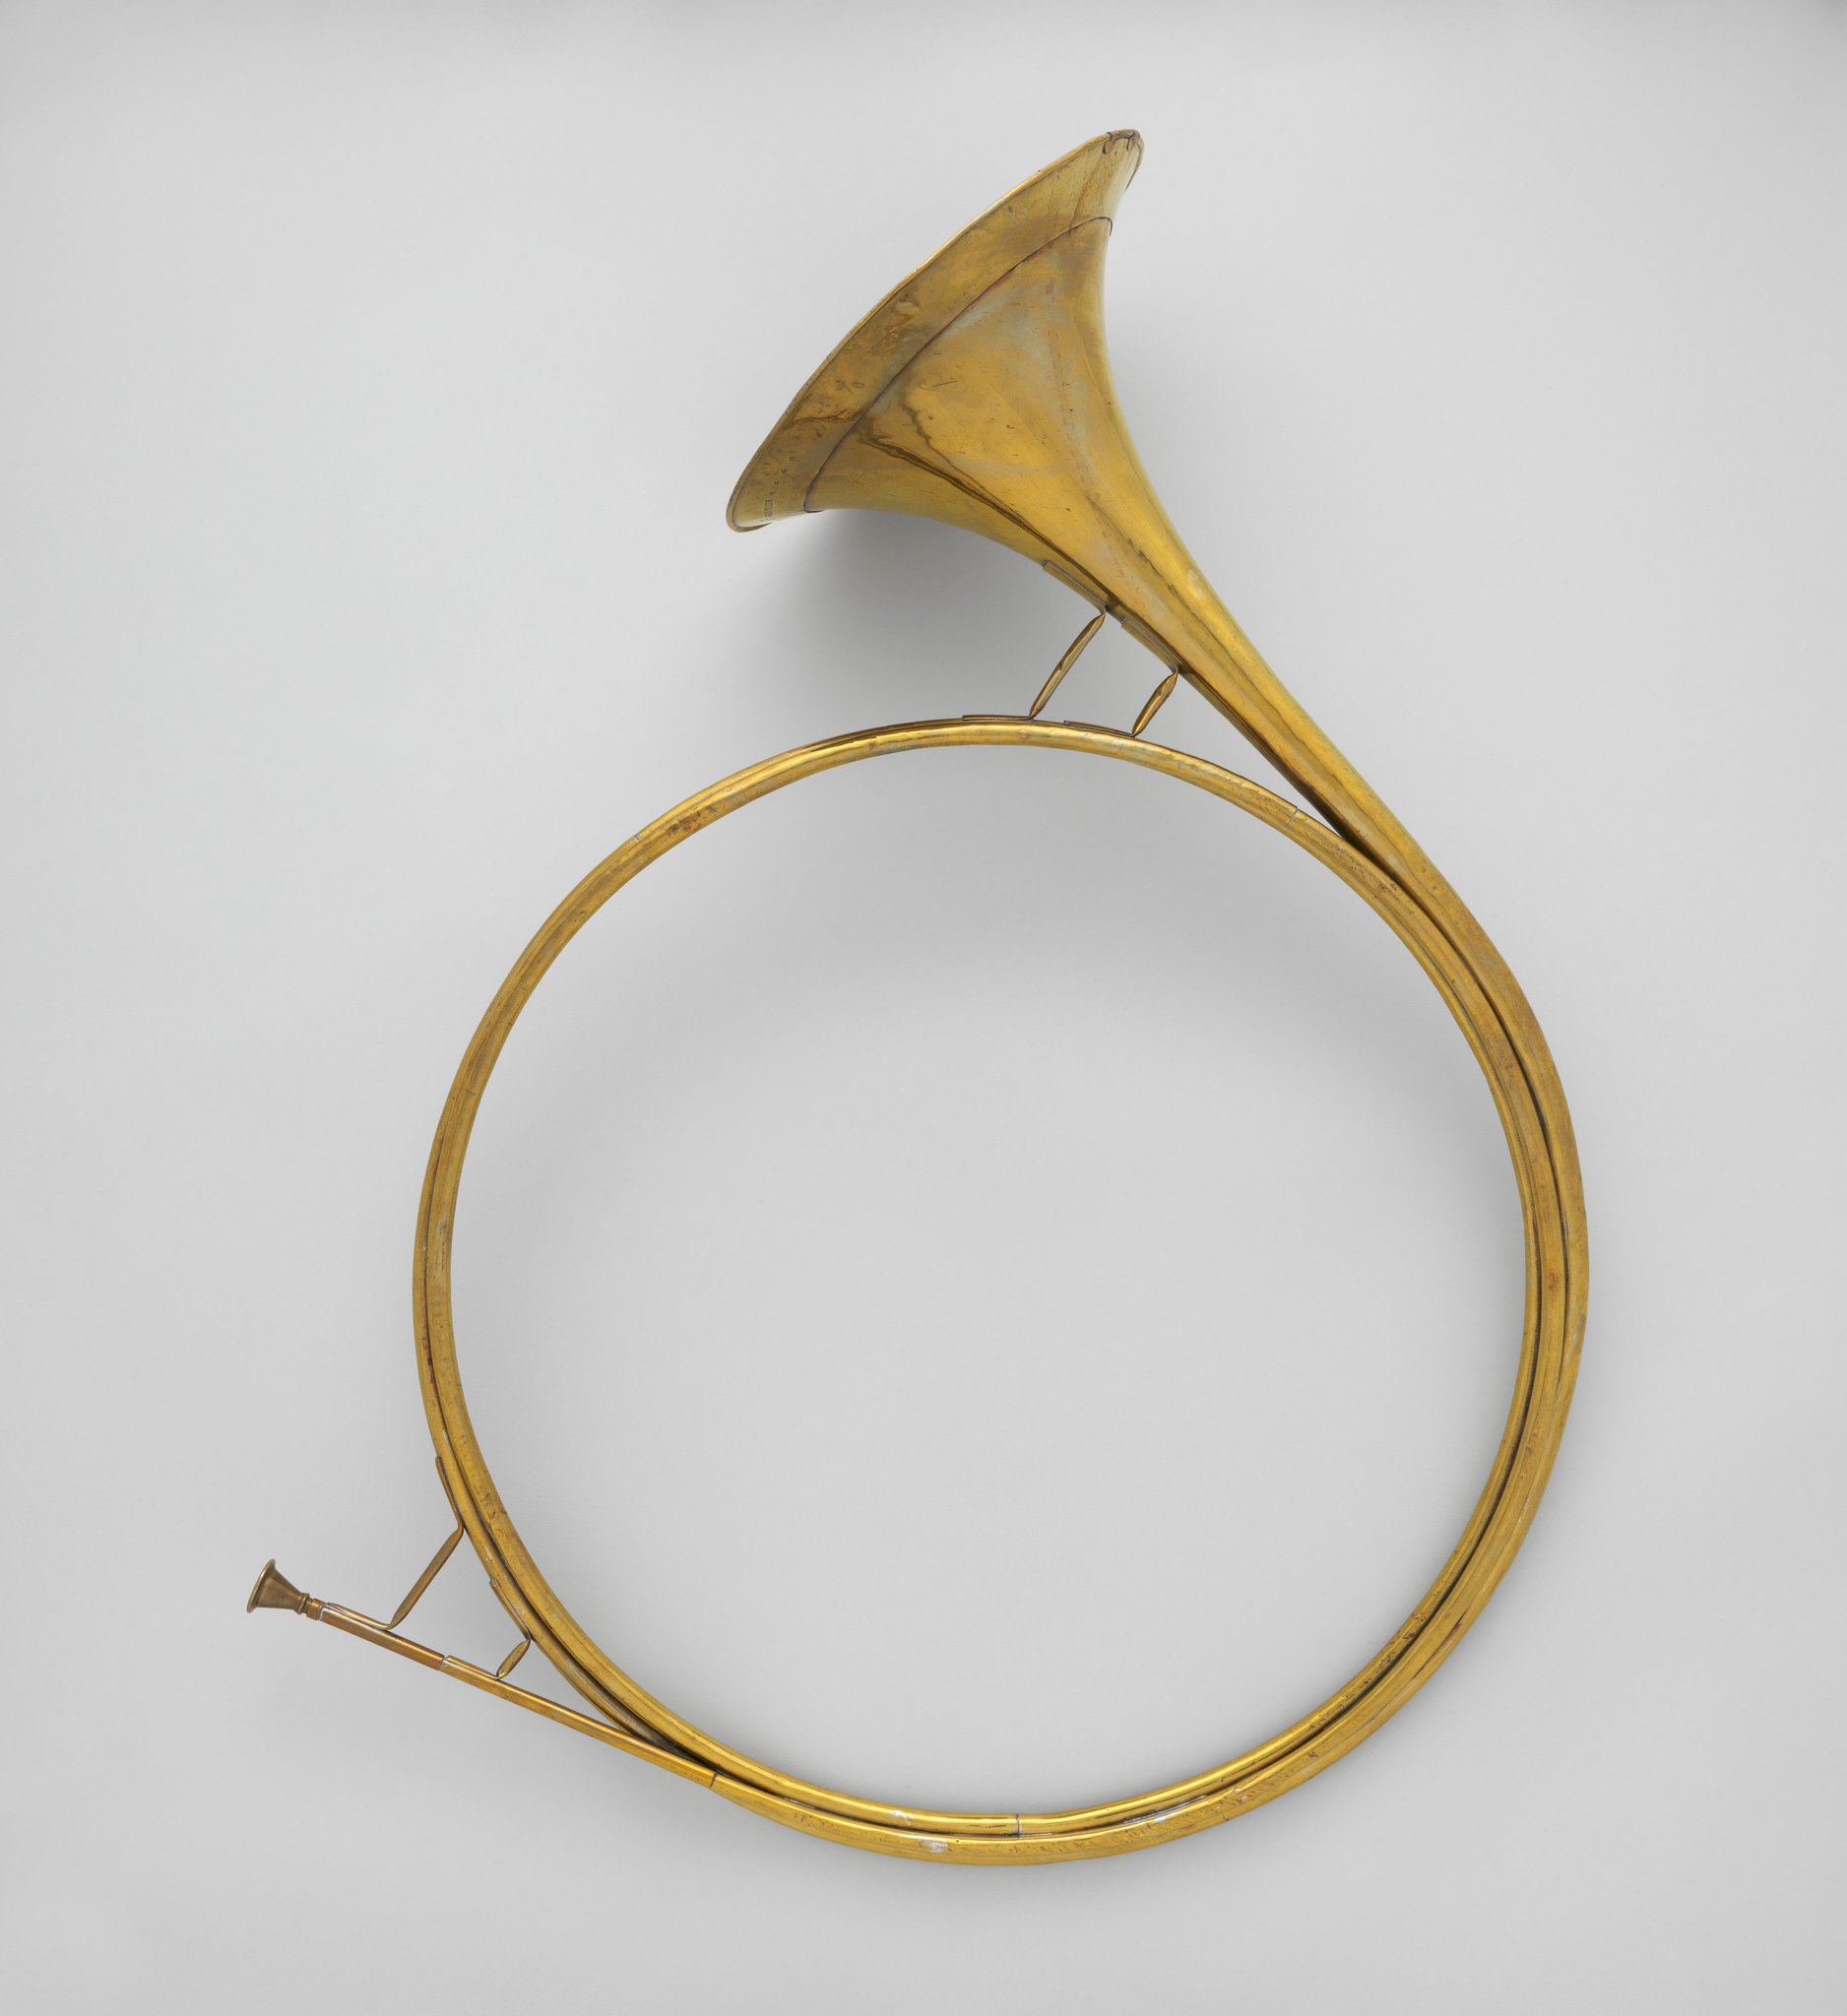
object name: trompe de chasse in d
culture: french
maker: courtois père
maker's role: maker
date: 1789-1801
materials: brass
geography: france